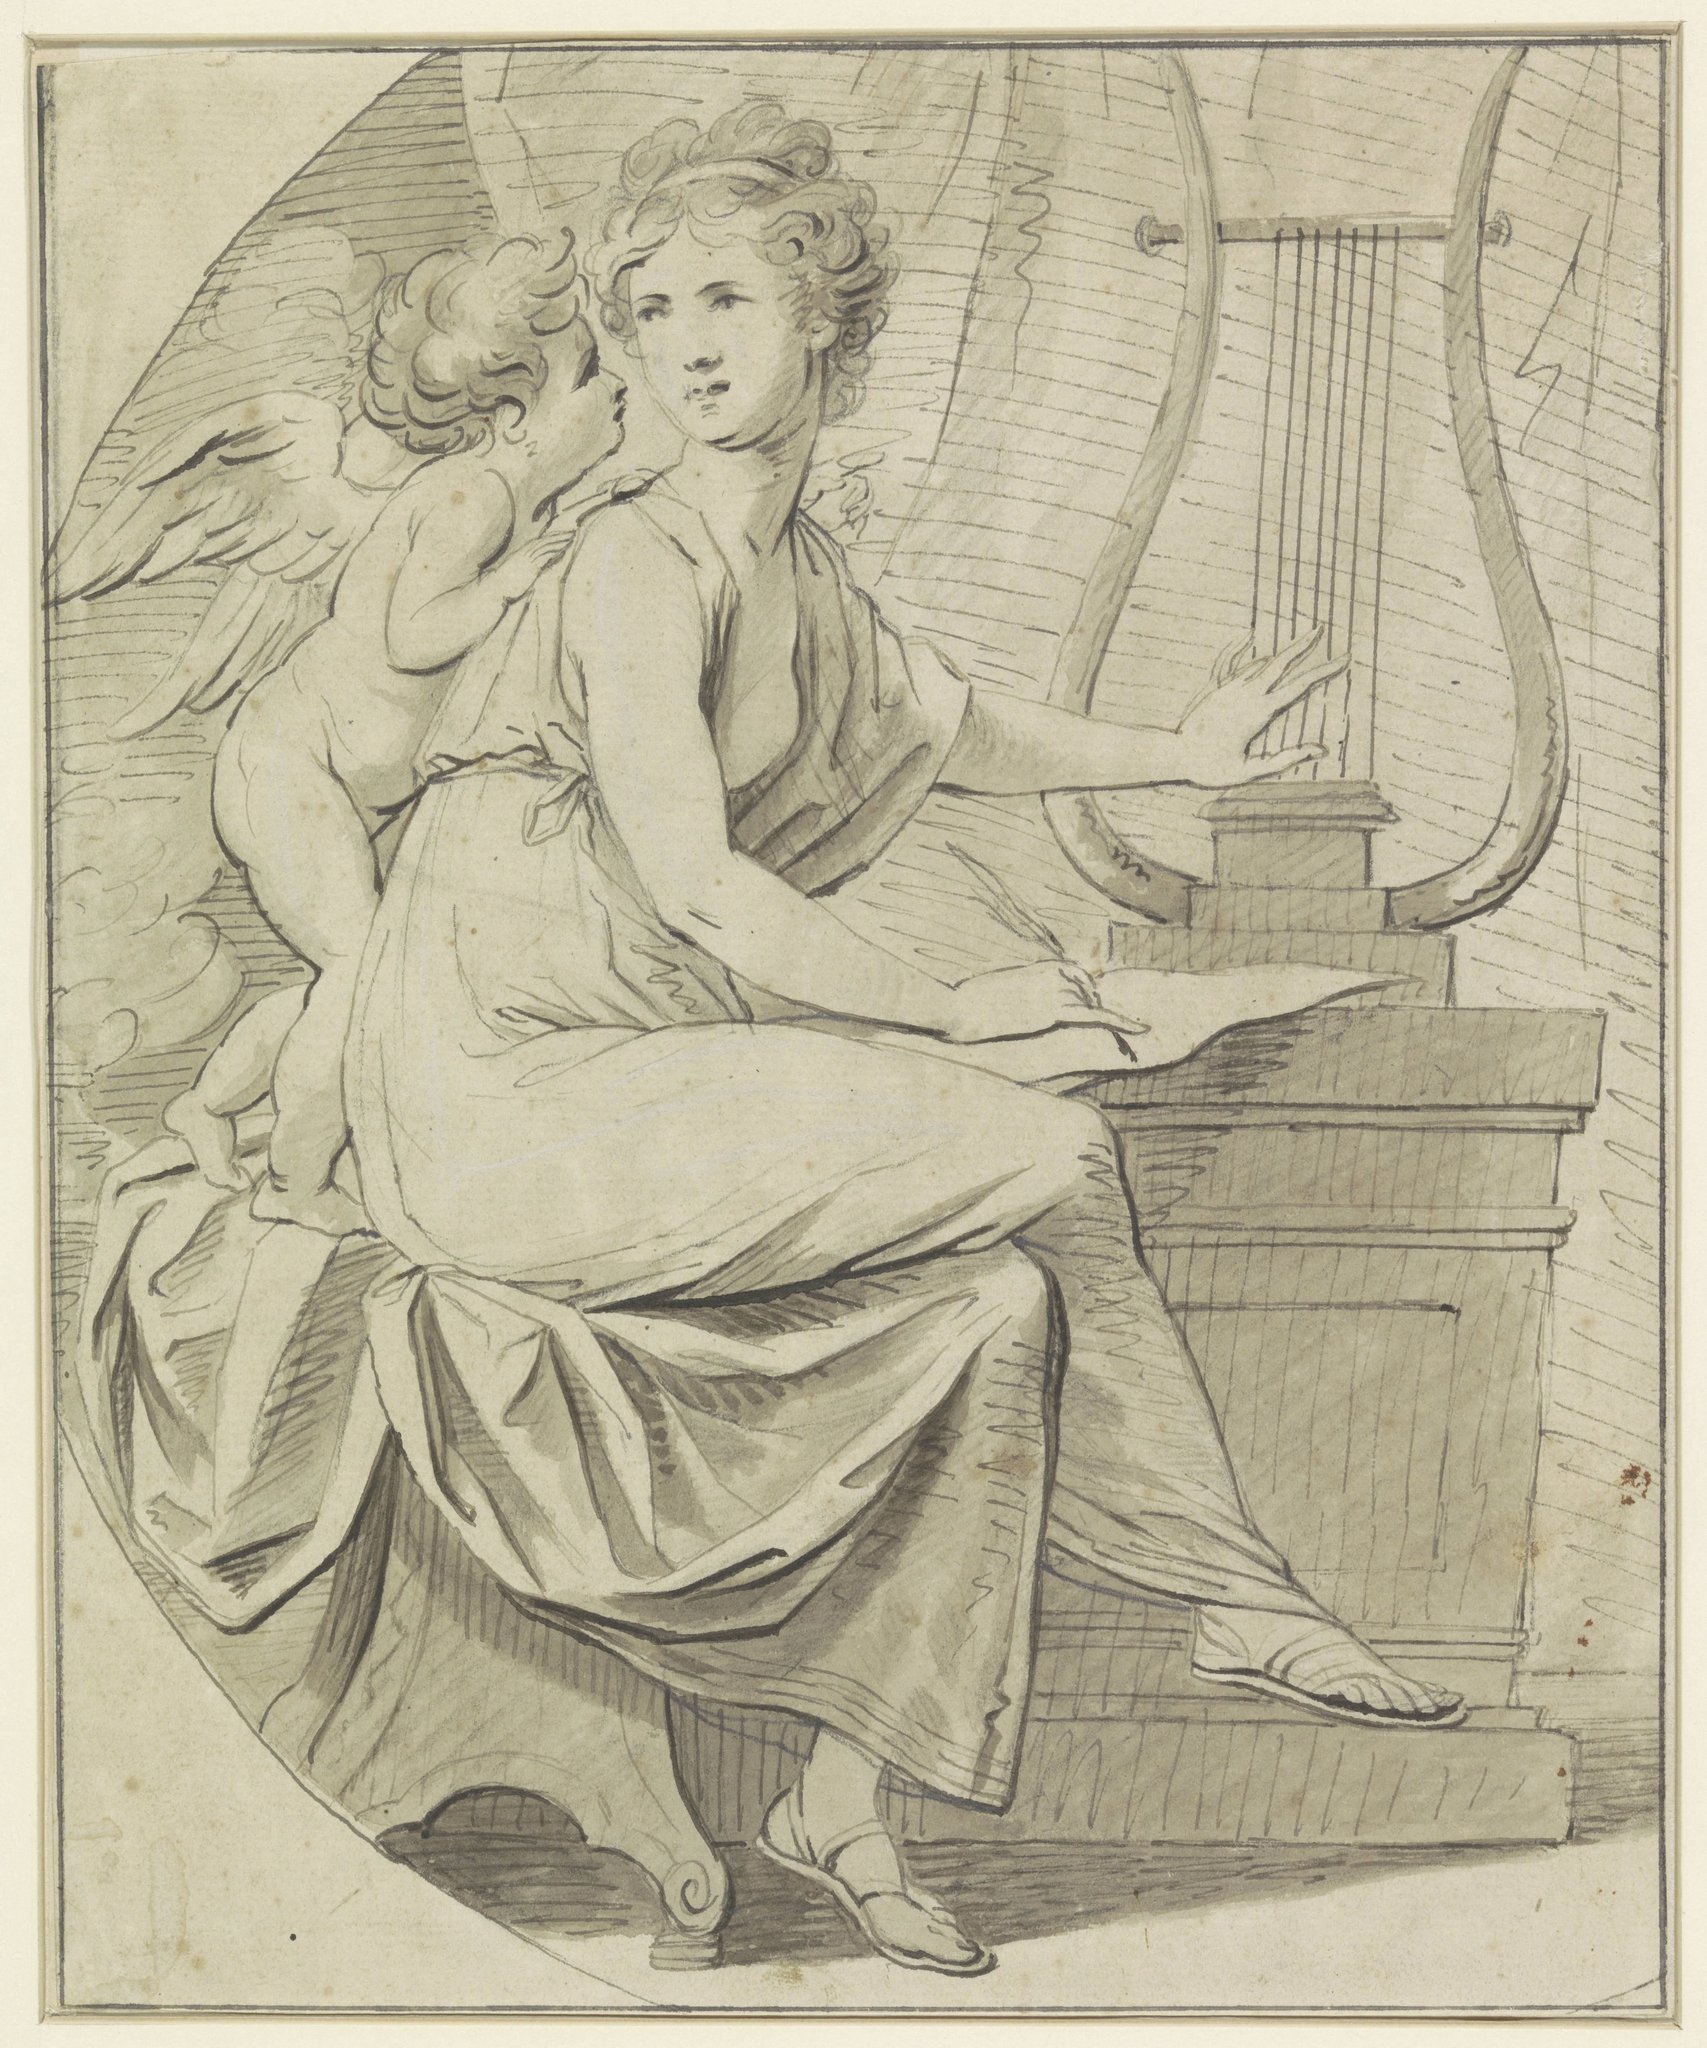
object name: drawing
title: Amor inspireert een jonge vrouw, die met de ene hand een lier tokkelt, en met de andere hand schrijft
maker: angelica kauffmann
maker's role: draughtsman, print maker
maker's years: 1741-1807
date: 1751-1807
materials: ink, paper, pencil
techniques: brush, pen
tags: lyre, cithara, psaltery, single muses